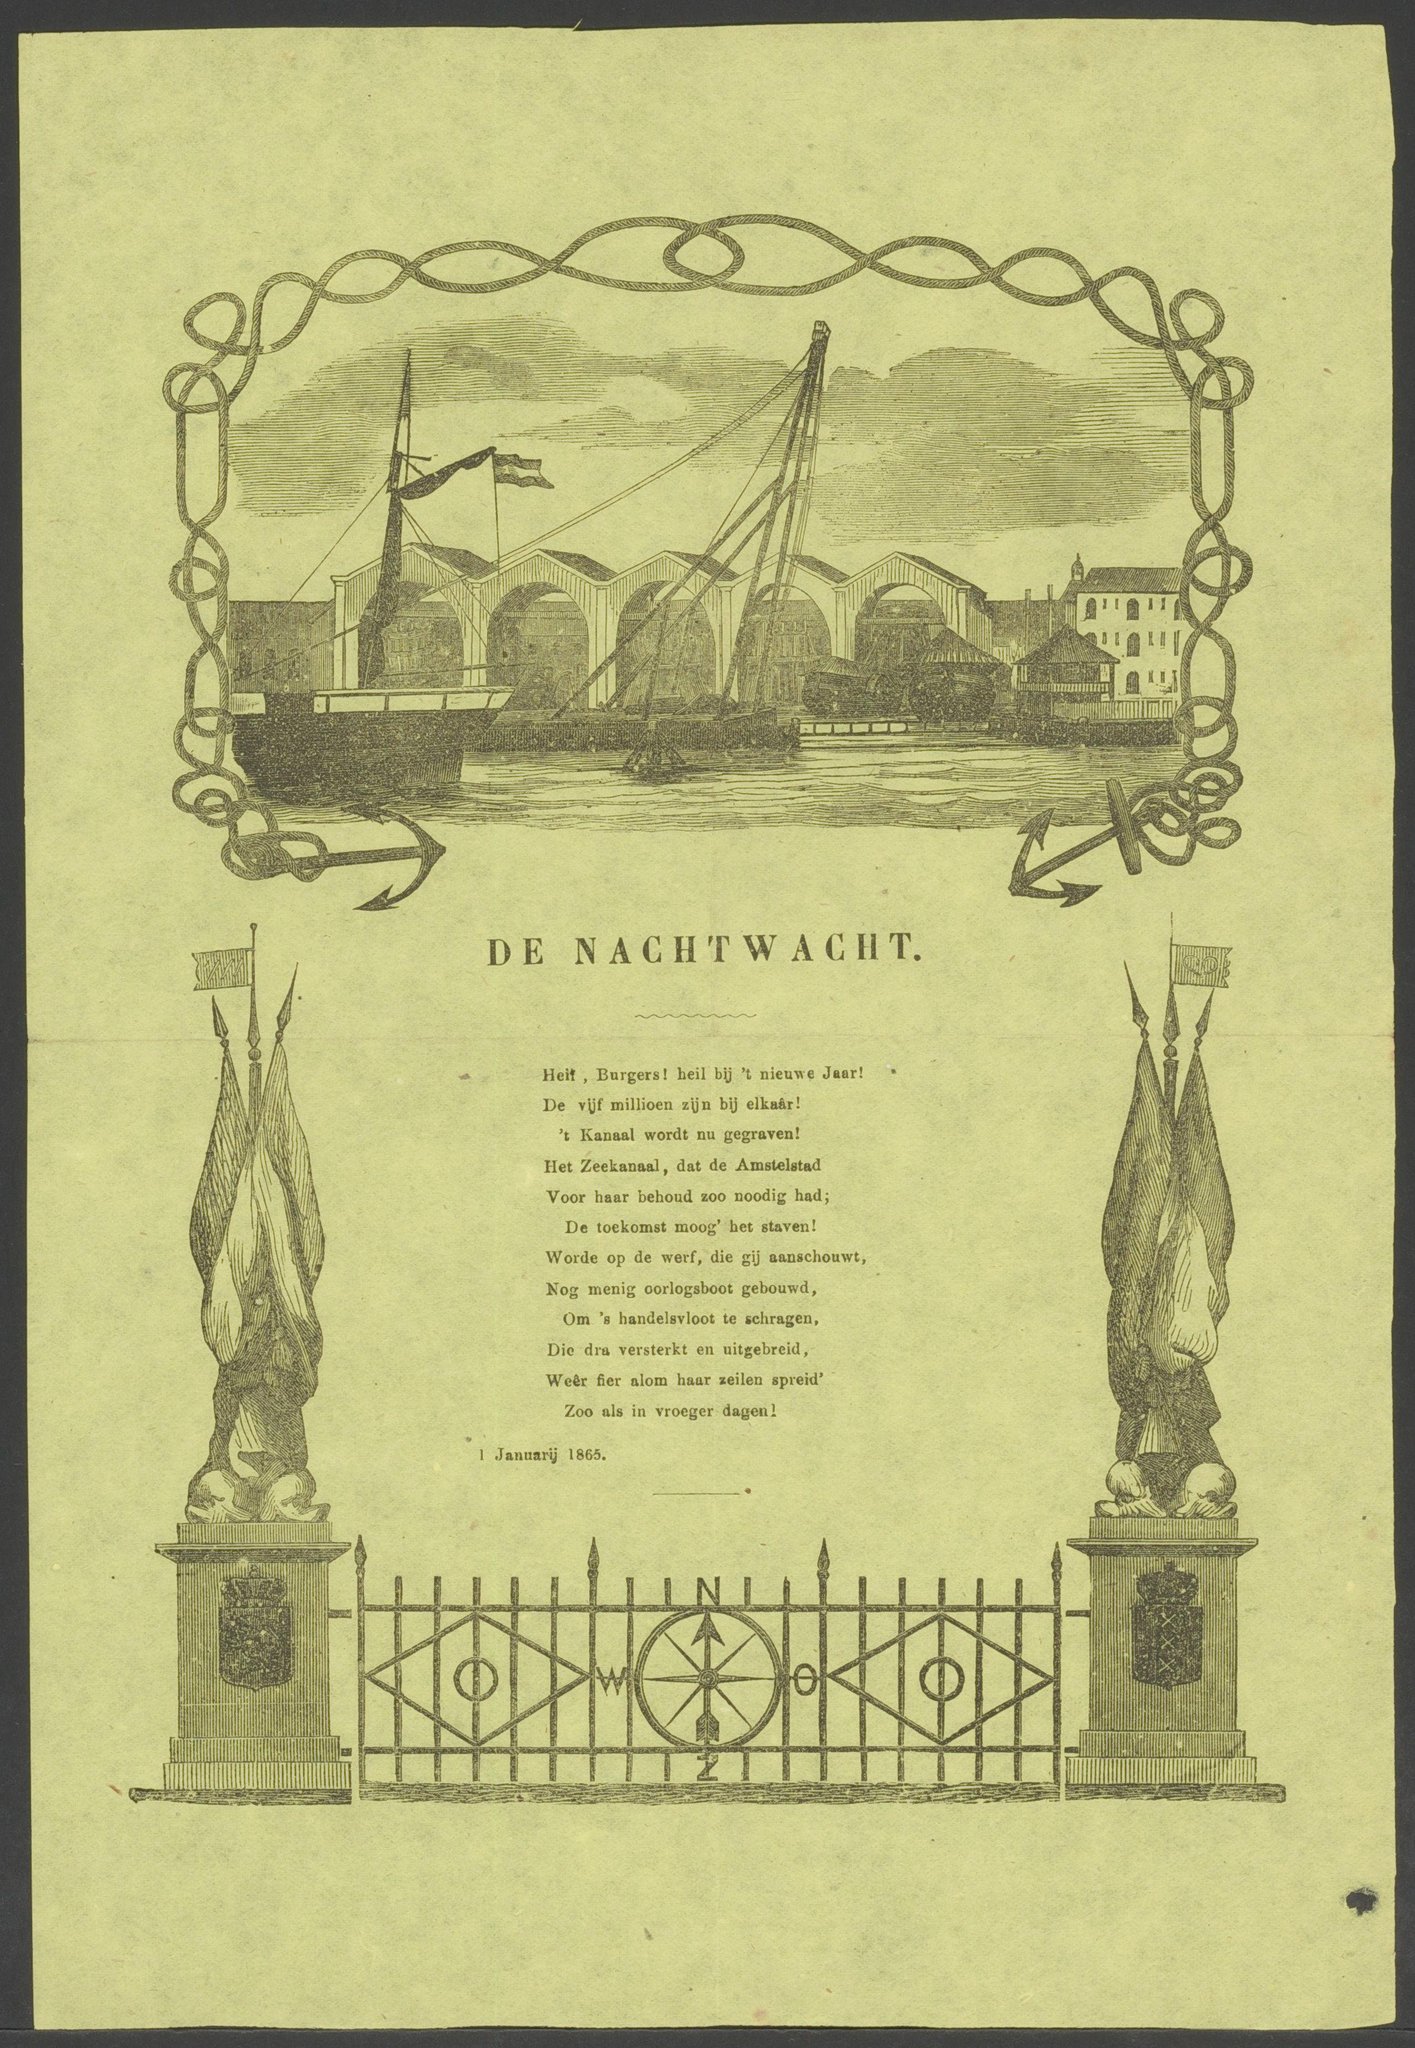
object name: print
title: De Nachtwacht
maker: Anonymous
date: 1864-1865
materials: paper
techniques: letterpress printing, engraving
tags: night patrol, shipyard, shipdock, amsterdam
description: Nieuwjaarswens van de Amsterdamse nachtwacht (ratelwacht), 1865. Centraal een gedicht, daarboven een gezicht op een scheepswerf te Amsterdam, mogelijk de Kadijken. Onderwerpsrubrieken binnen de Atlas Zeden en Gewoonten: Zeden en gewoonten in engeren zin, Volksleven, Volksbladen, Nieuwjaars- en Kerstwenschen, Amsterdam.